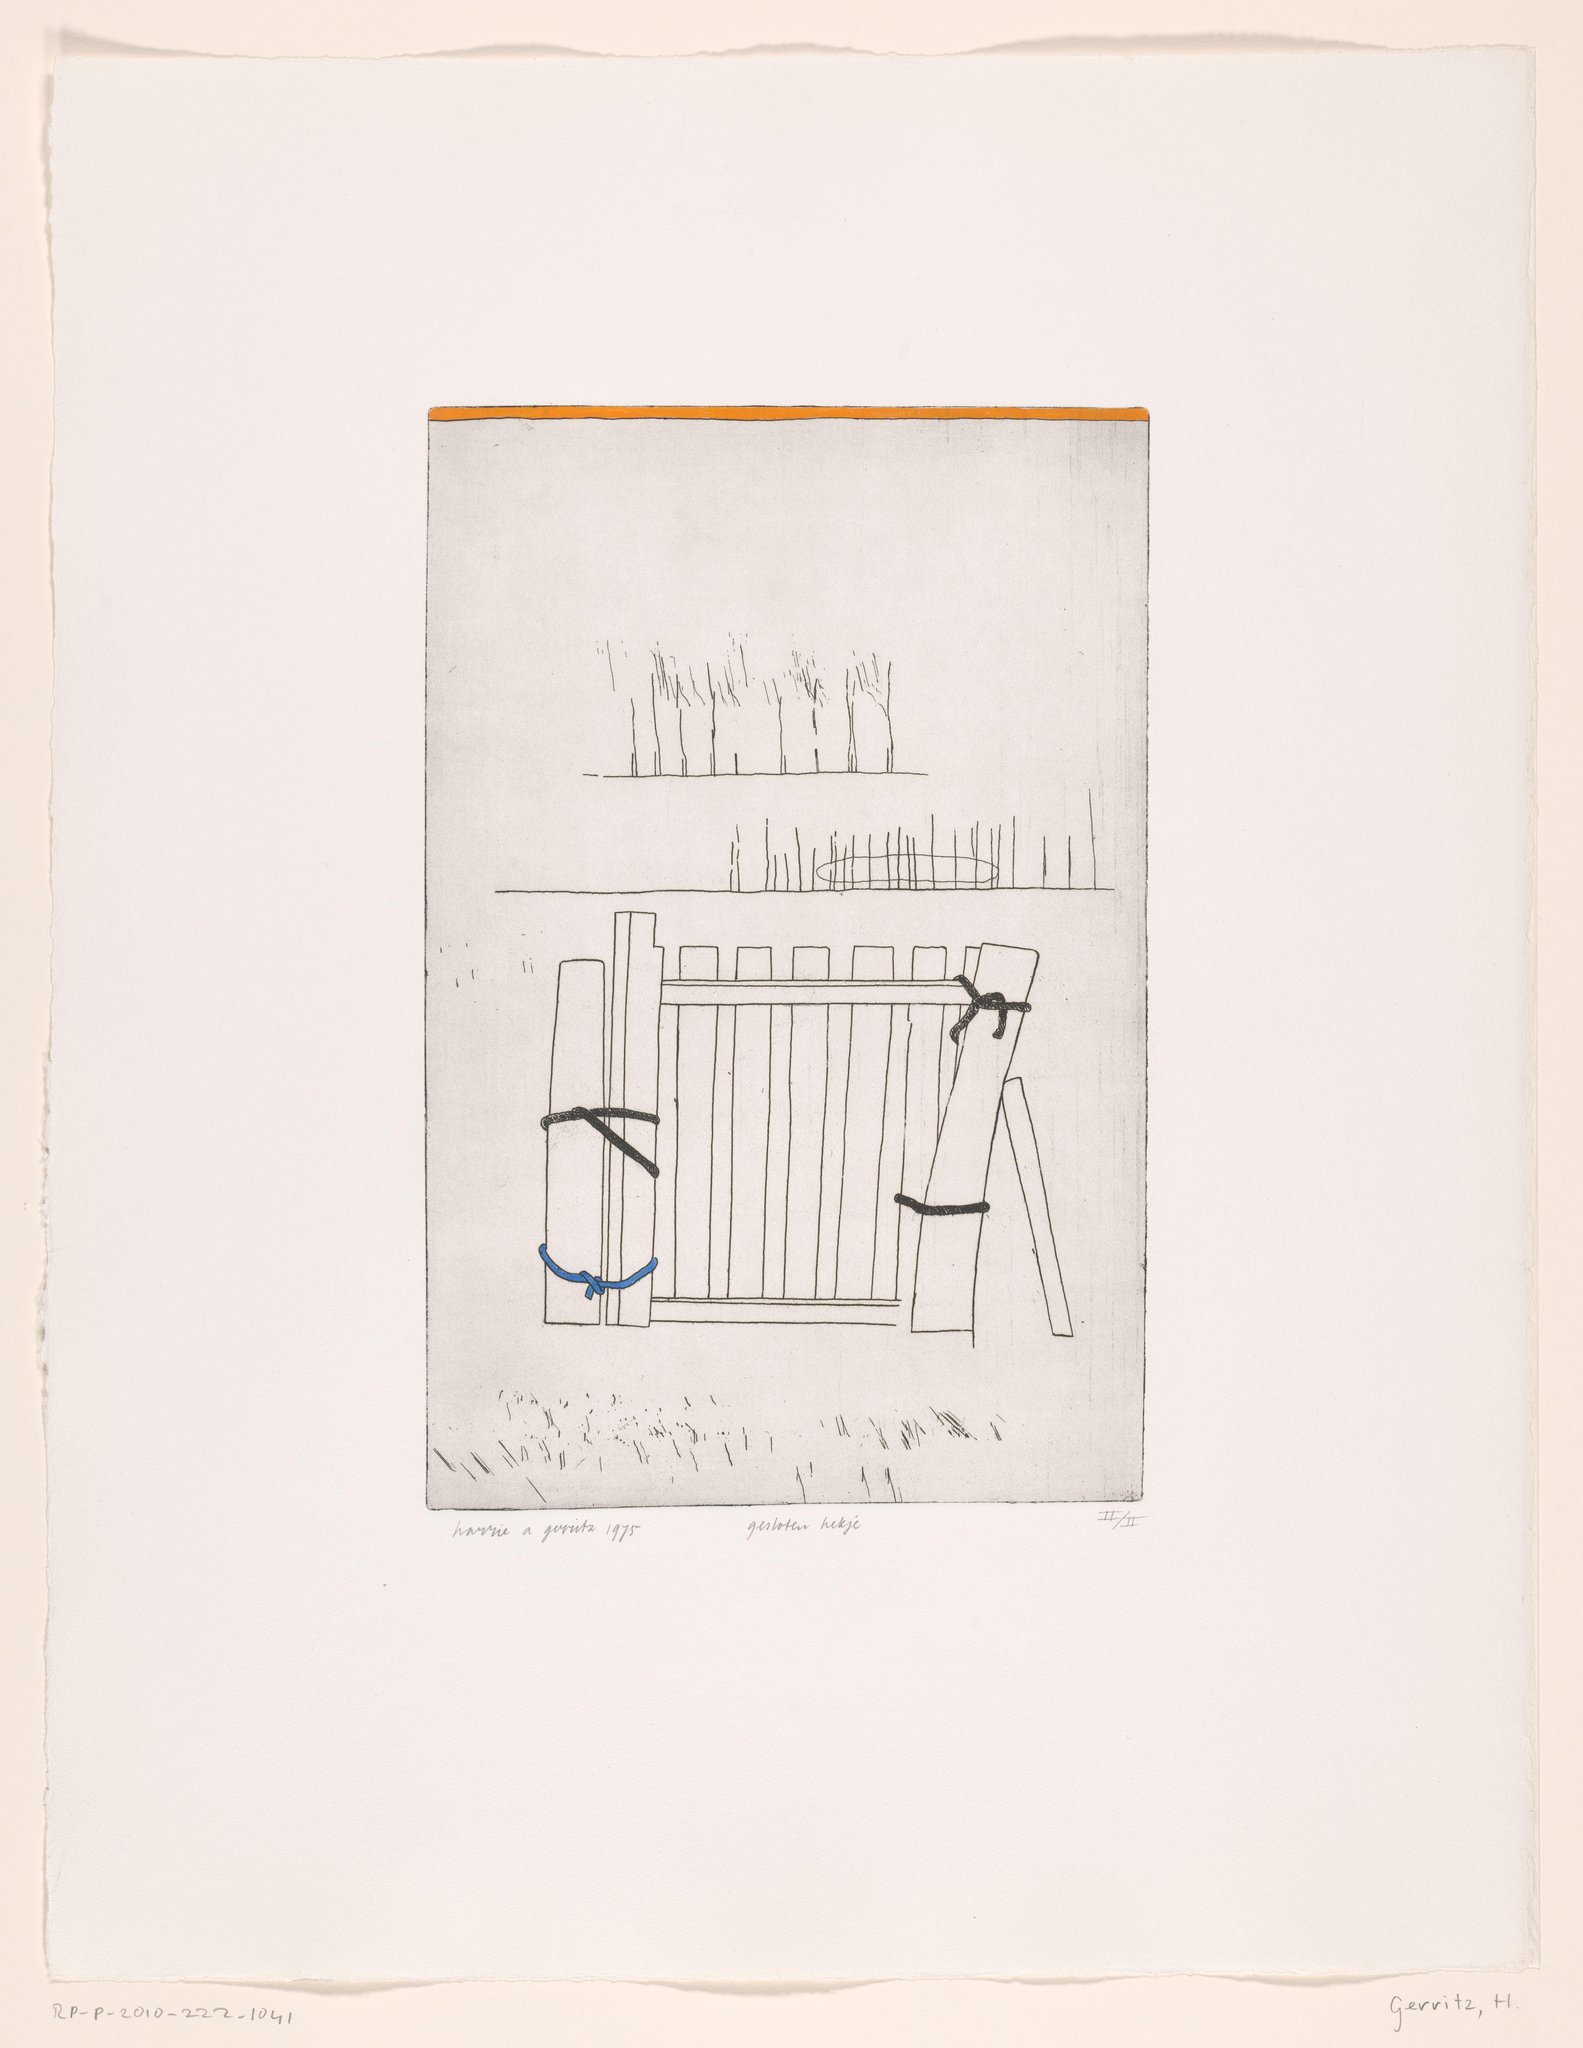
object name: print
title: Gesloten hekje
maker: harrie a. gerritz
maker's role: draughtsman, painter, print maker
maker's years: 1940-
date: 1975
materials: paper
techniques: etching, hand coloring, intaglio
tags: landscapes in the temperate zone, receiver, fence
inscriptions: collector's mark: Lugt 2228, inscription: ‘Shirley’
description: Hek dat door middel van touwen gesloten is.